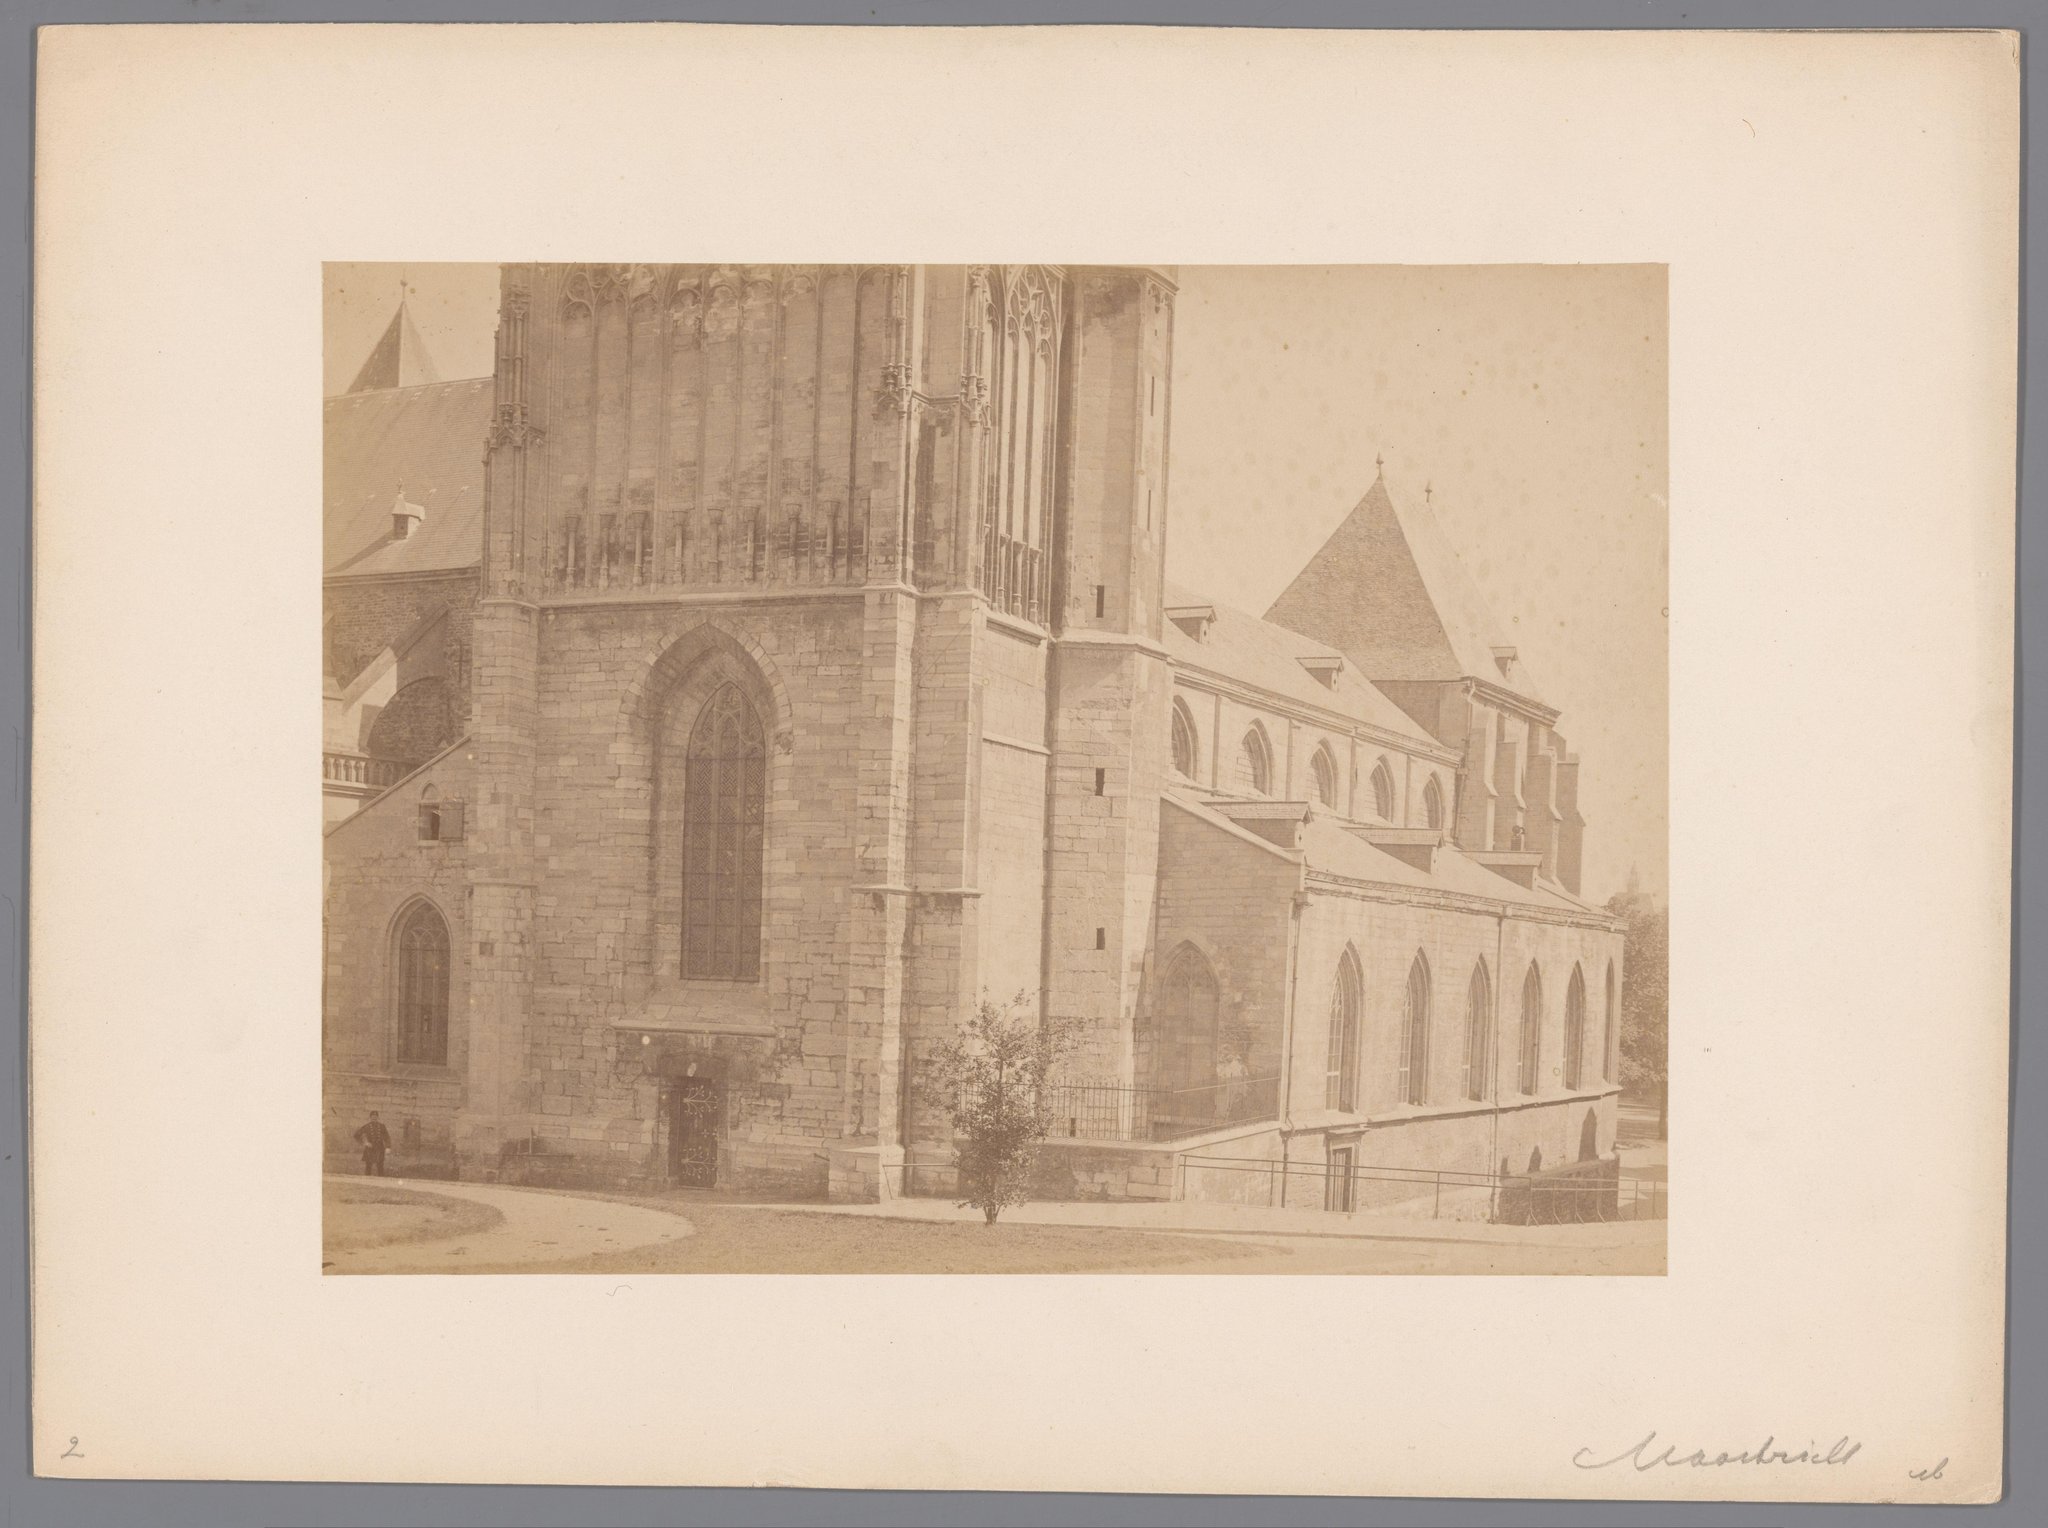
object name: photograph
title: Gedeelte van de Sint-Janskerk te Maastricht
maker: anoniem (monumentenzorg)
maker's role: fotograaf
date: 1893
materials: cardboard, photographic support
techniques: albumen print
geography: maastricht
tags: church (exterior)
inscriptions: annotation: ‘St. Janskerk te Maastricht (L.)/ Mei 1893’, annotation: ‘Maastricht’